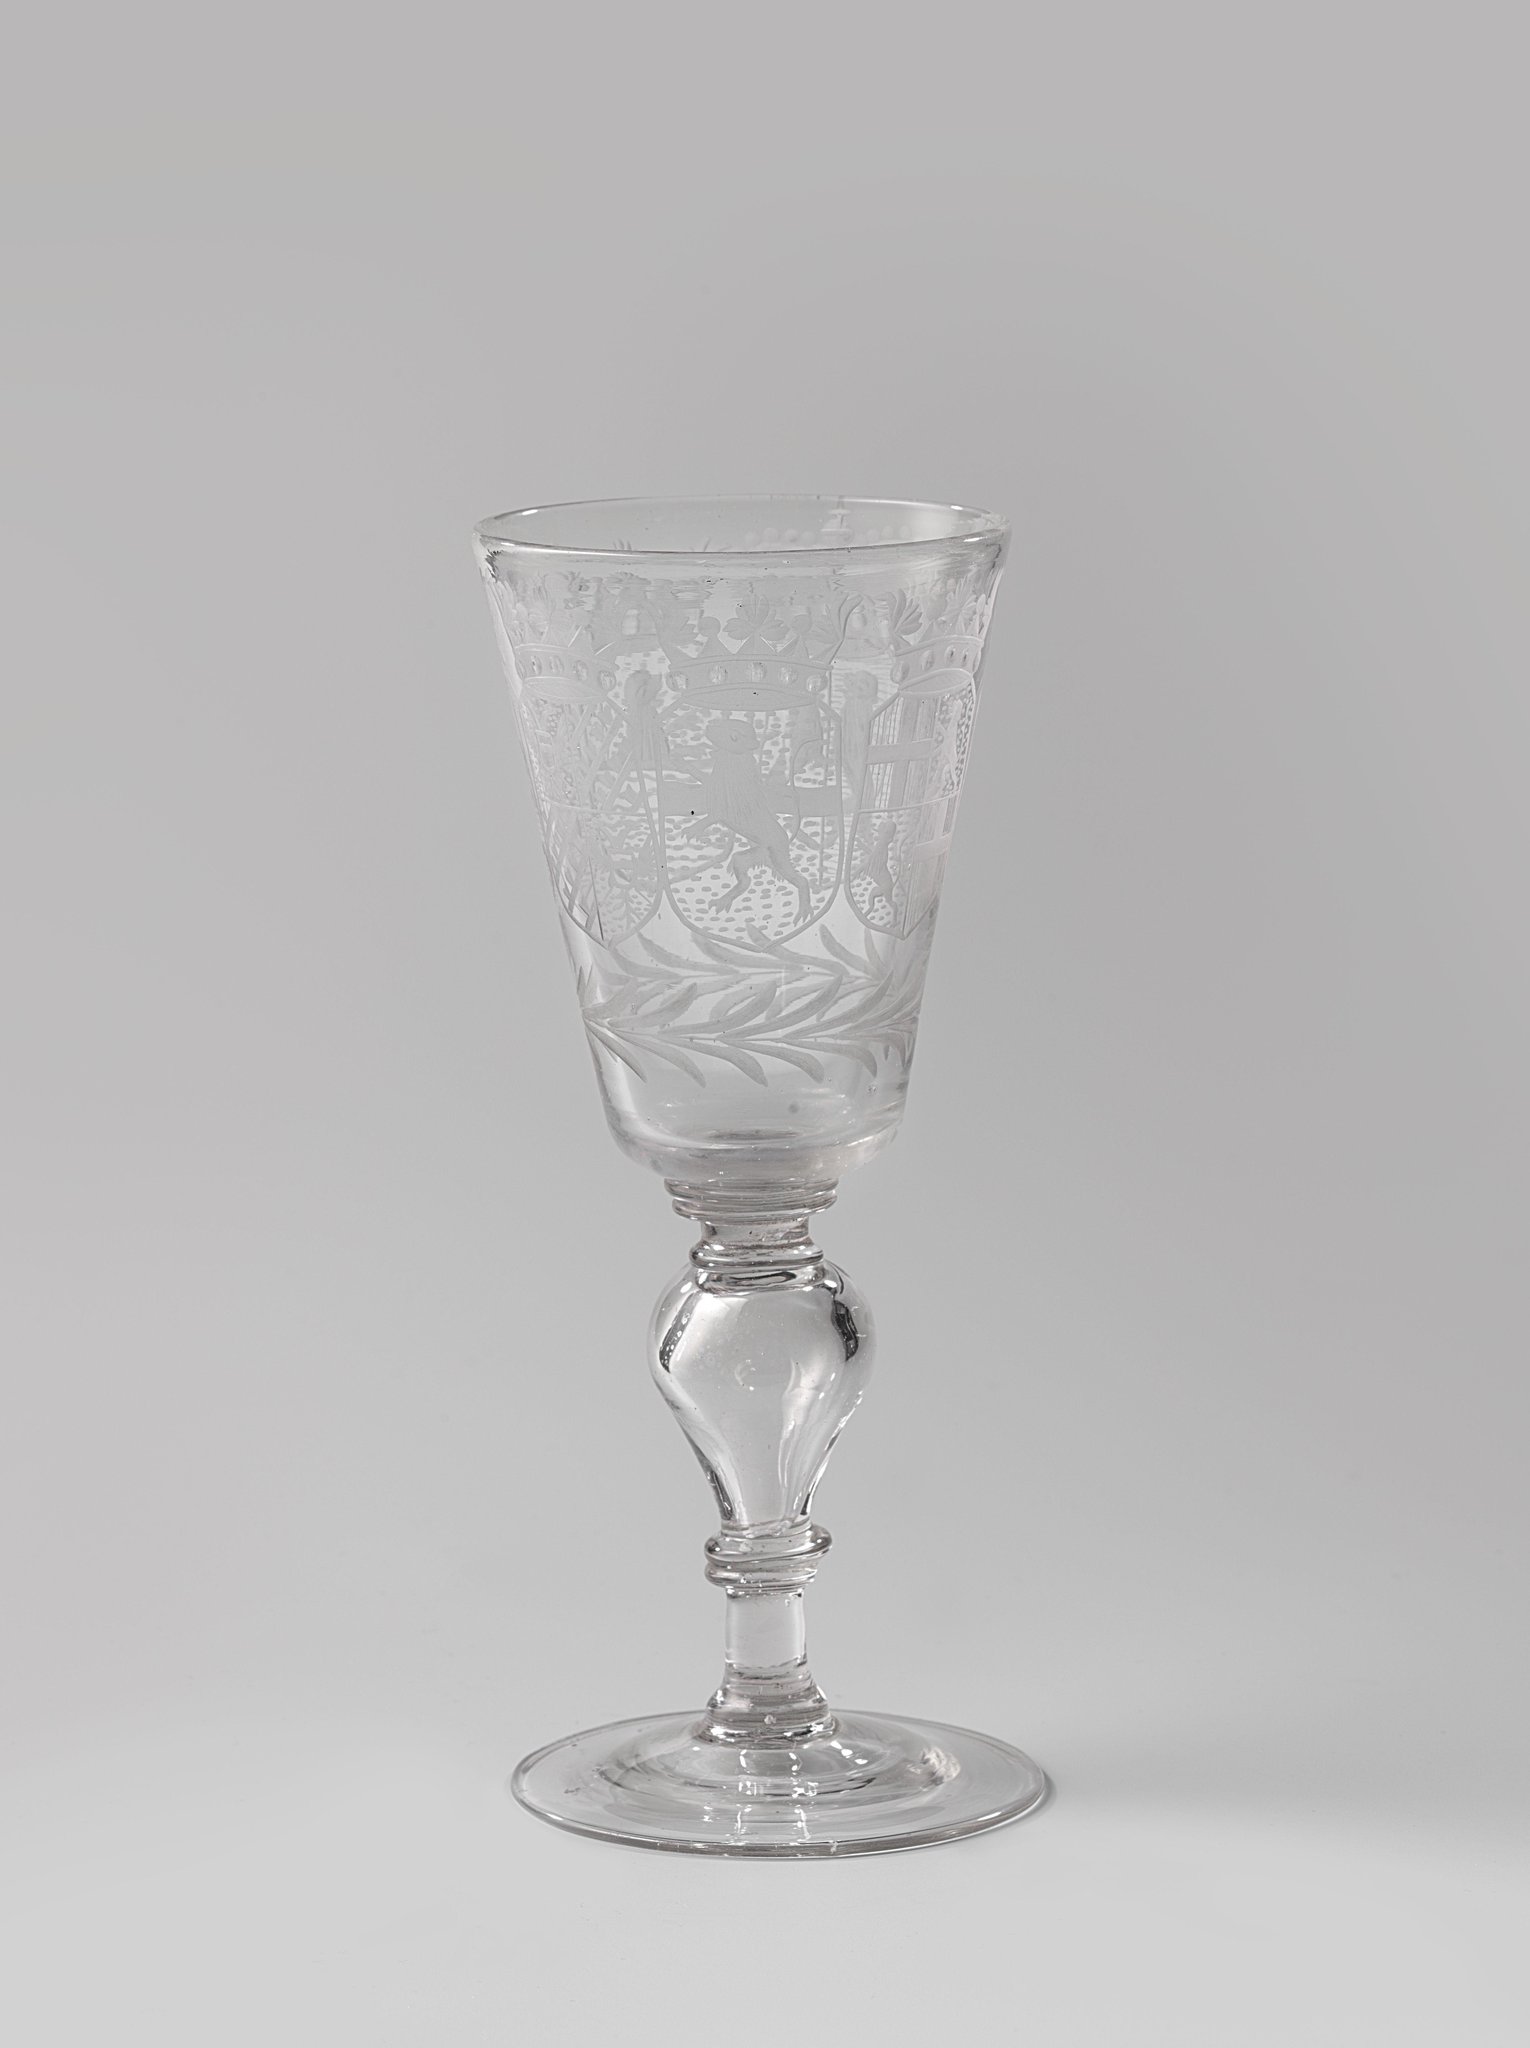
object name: goblet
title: Bokaal met de wapens van de Zeven Verenigde Gewesten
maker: Anonymous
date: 1700-1725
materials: glass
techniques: glassblowing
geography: germany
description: Bokaal met licht gewelfde voet met omgeslagen rand. Holle balusterstam met vier schijven. Op de conische kelk de gekroonde wapens van de Zeven Verenigde Gewesten.